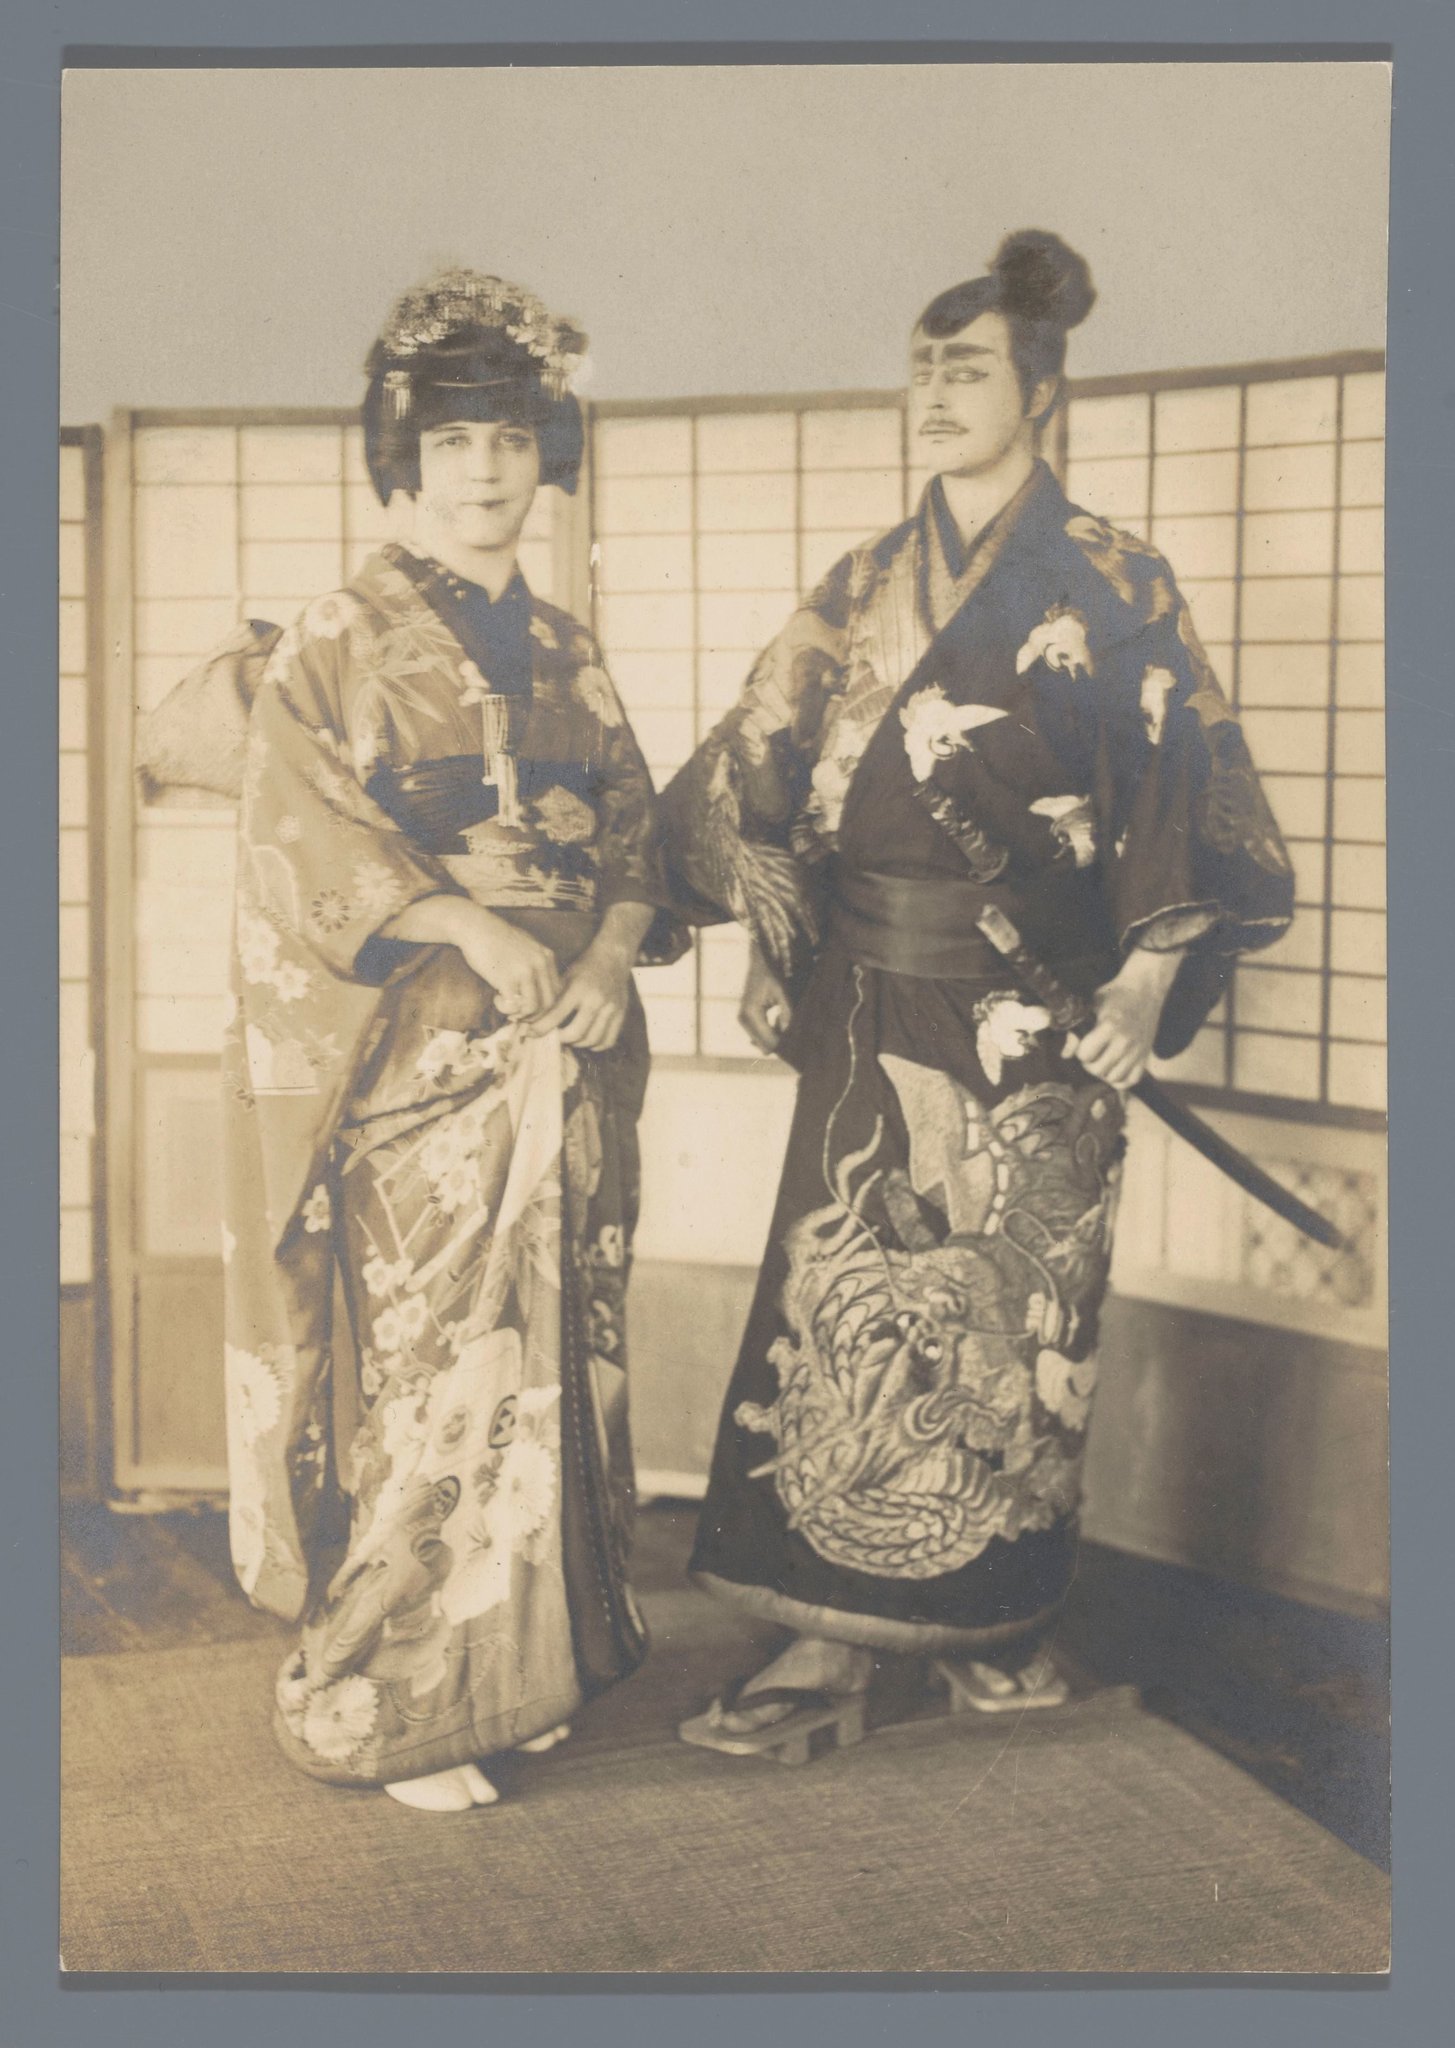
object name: photograph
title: Man en vrouw in kimono, Japan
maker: jan adriani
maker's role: fotograaf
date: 1900-1949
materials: paper, photographic support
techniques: gelatin silver print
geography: japan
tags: folk costume, regional costume